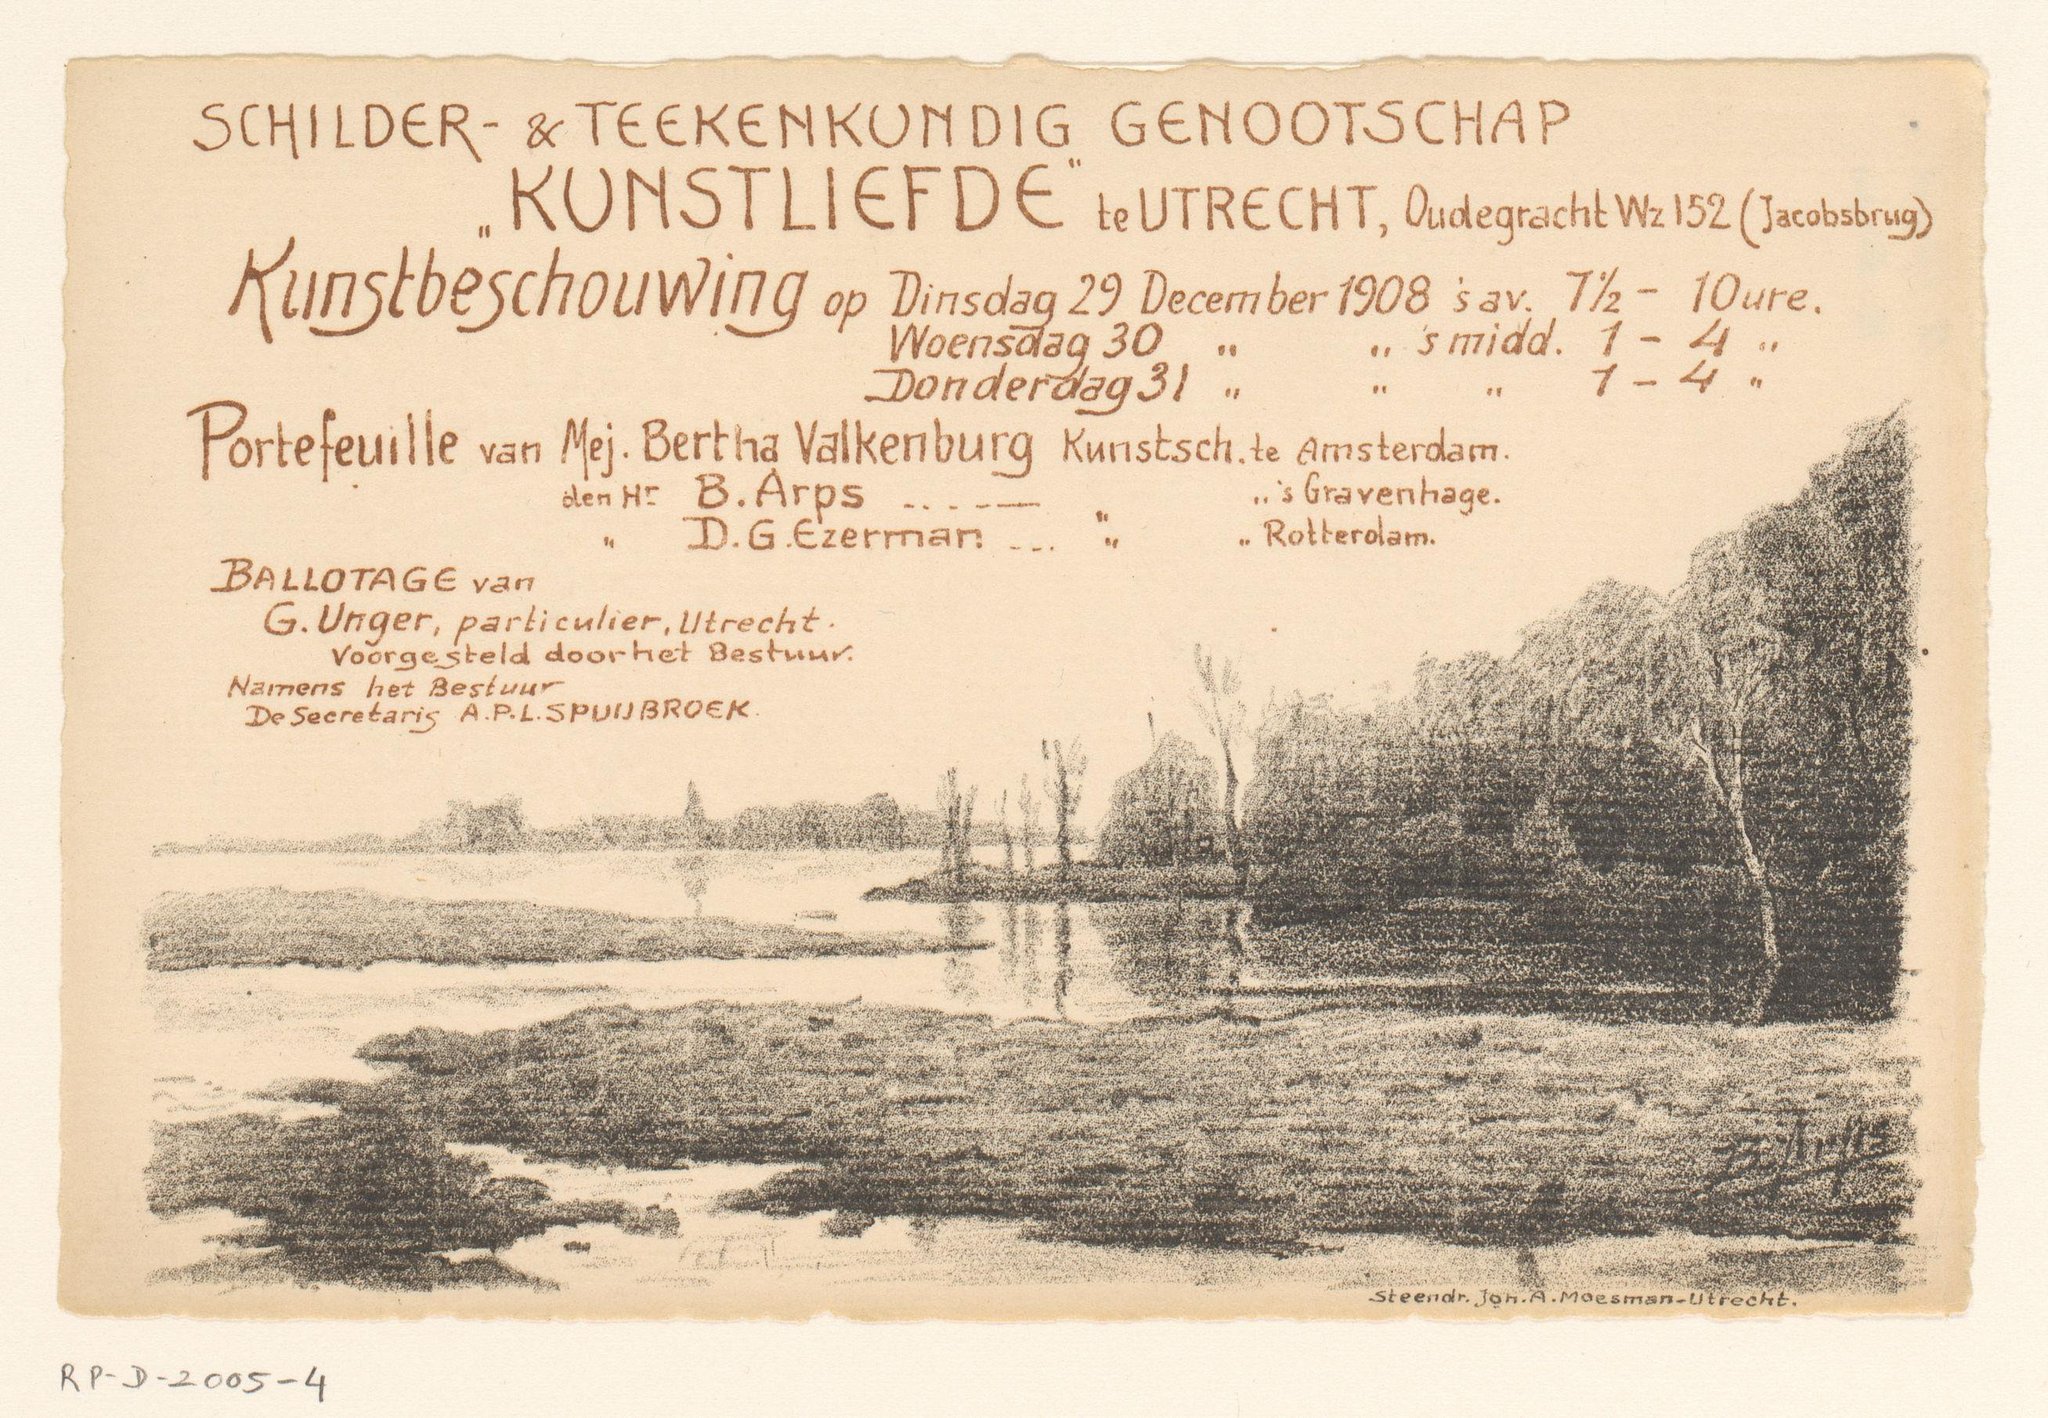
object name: invitation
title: Uitnodiging van Schilder- en Teekenkundig Genootschap "Kunstliefde" voor een kunstbeschouwing, 29-31 december 1908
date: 1908-1912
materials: paper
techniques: lithograph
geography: utrecht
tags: print maker, rotterdam, dirk gerard ezerman, painter, draughtsman, bernardus arps, criticizing and discussing art, art criticism, circle, club of artists, collecting and exhibiting products of the fine arts, water course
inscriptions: collector's mark: Lugt 2228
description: Waterlandschap. Uitnodiging van Schilder- en Teekenkundig Genootschap "Kunstliefde" voor een kunstbeschouwing op 29-31 december 1908 van de portefeuille van de kunstschilders Bertha Valkenburg, B. Arps en D.G. Ezerman.